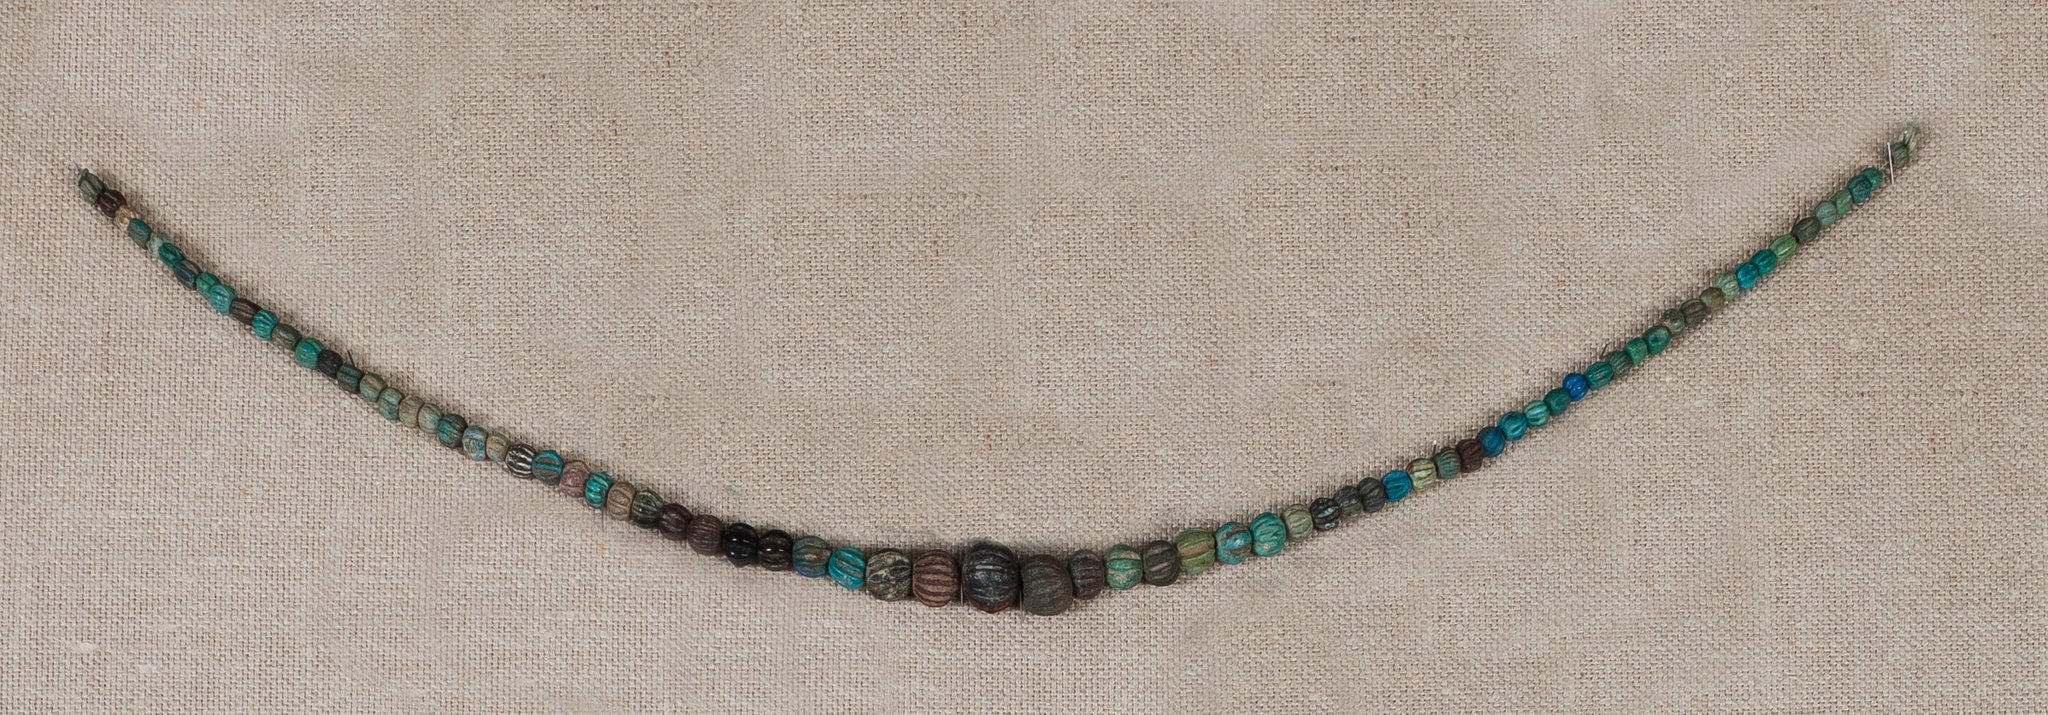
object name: necklace, bead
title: Necklace of striated beads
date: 1981-1295 BCE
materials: faience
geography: egypt